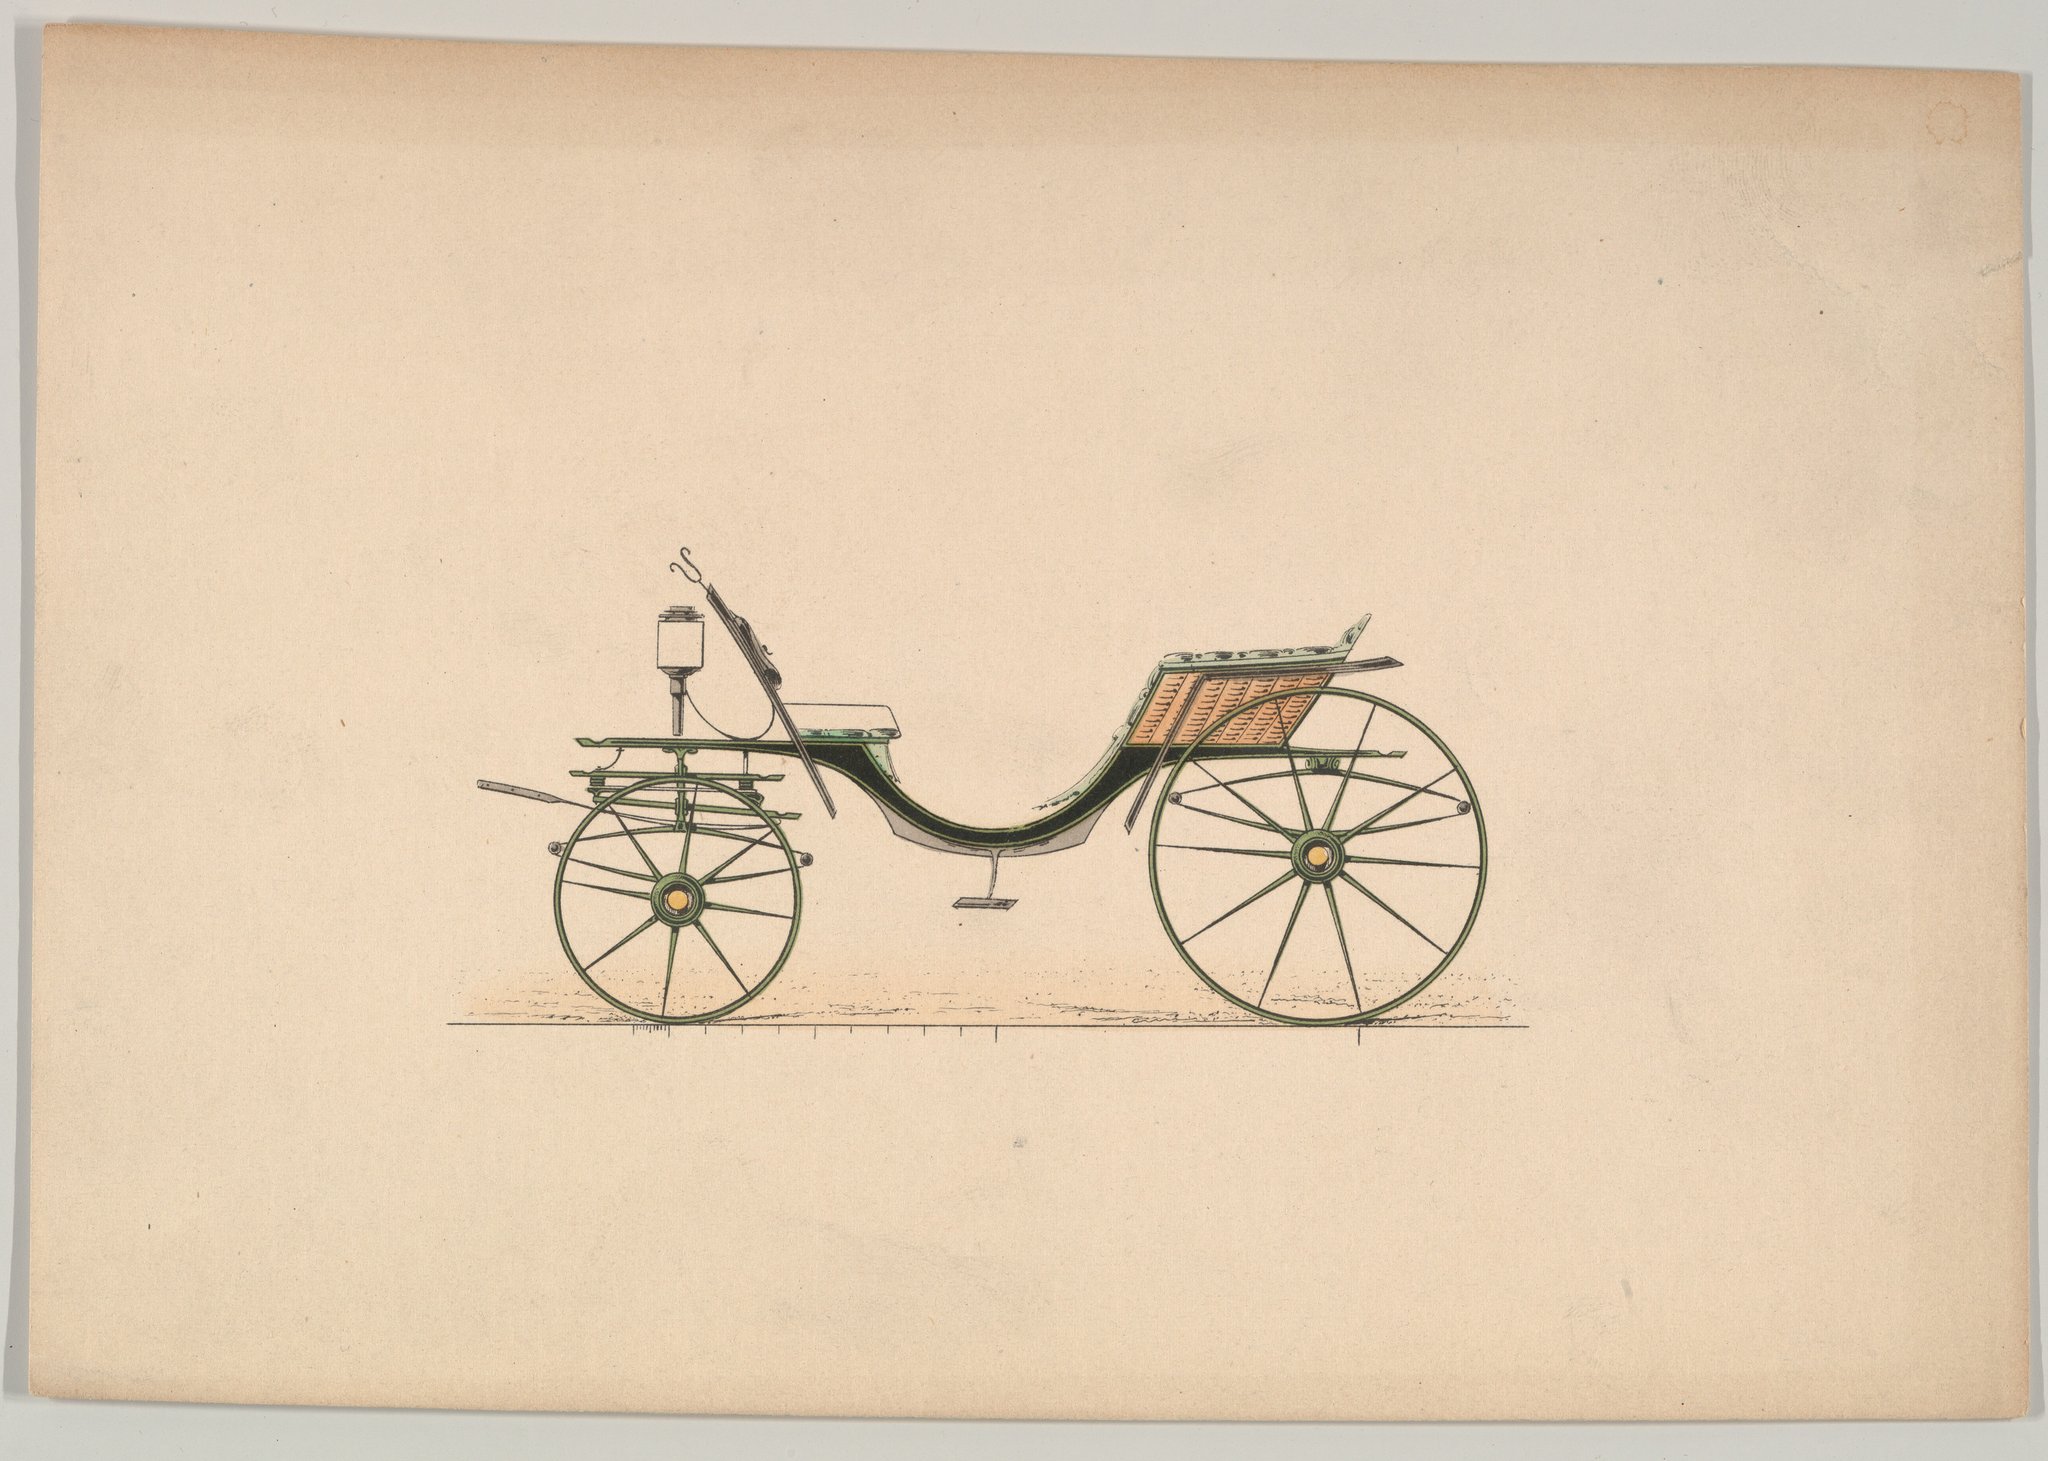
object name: print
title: Design for a Phaeton (no number)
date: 1860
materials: gum arabic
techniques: hand coloring, lithograph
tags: carriages